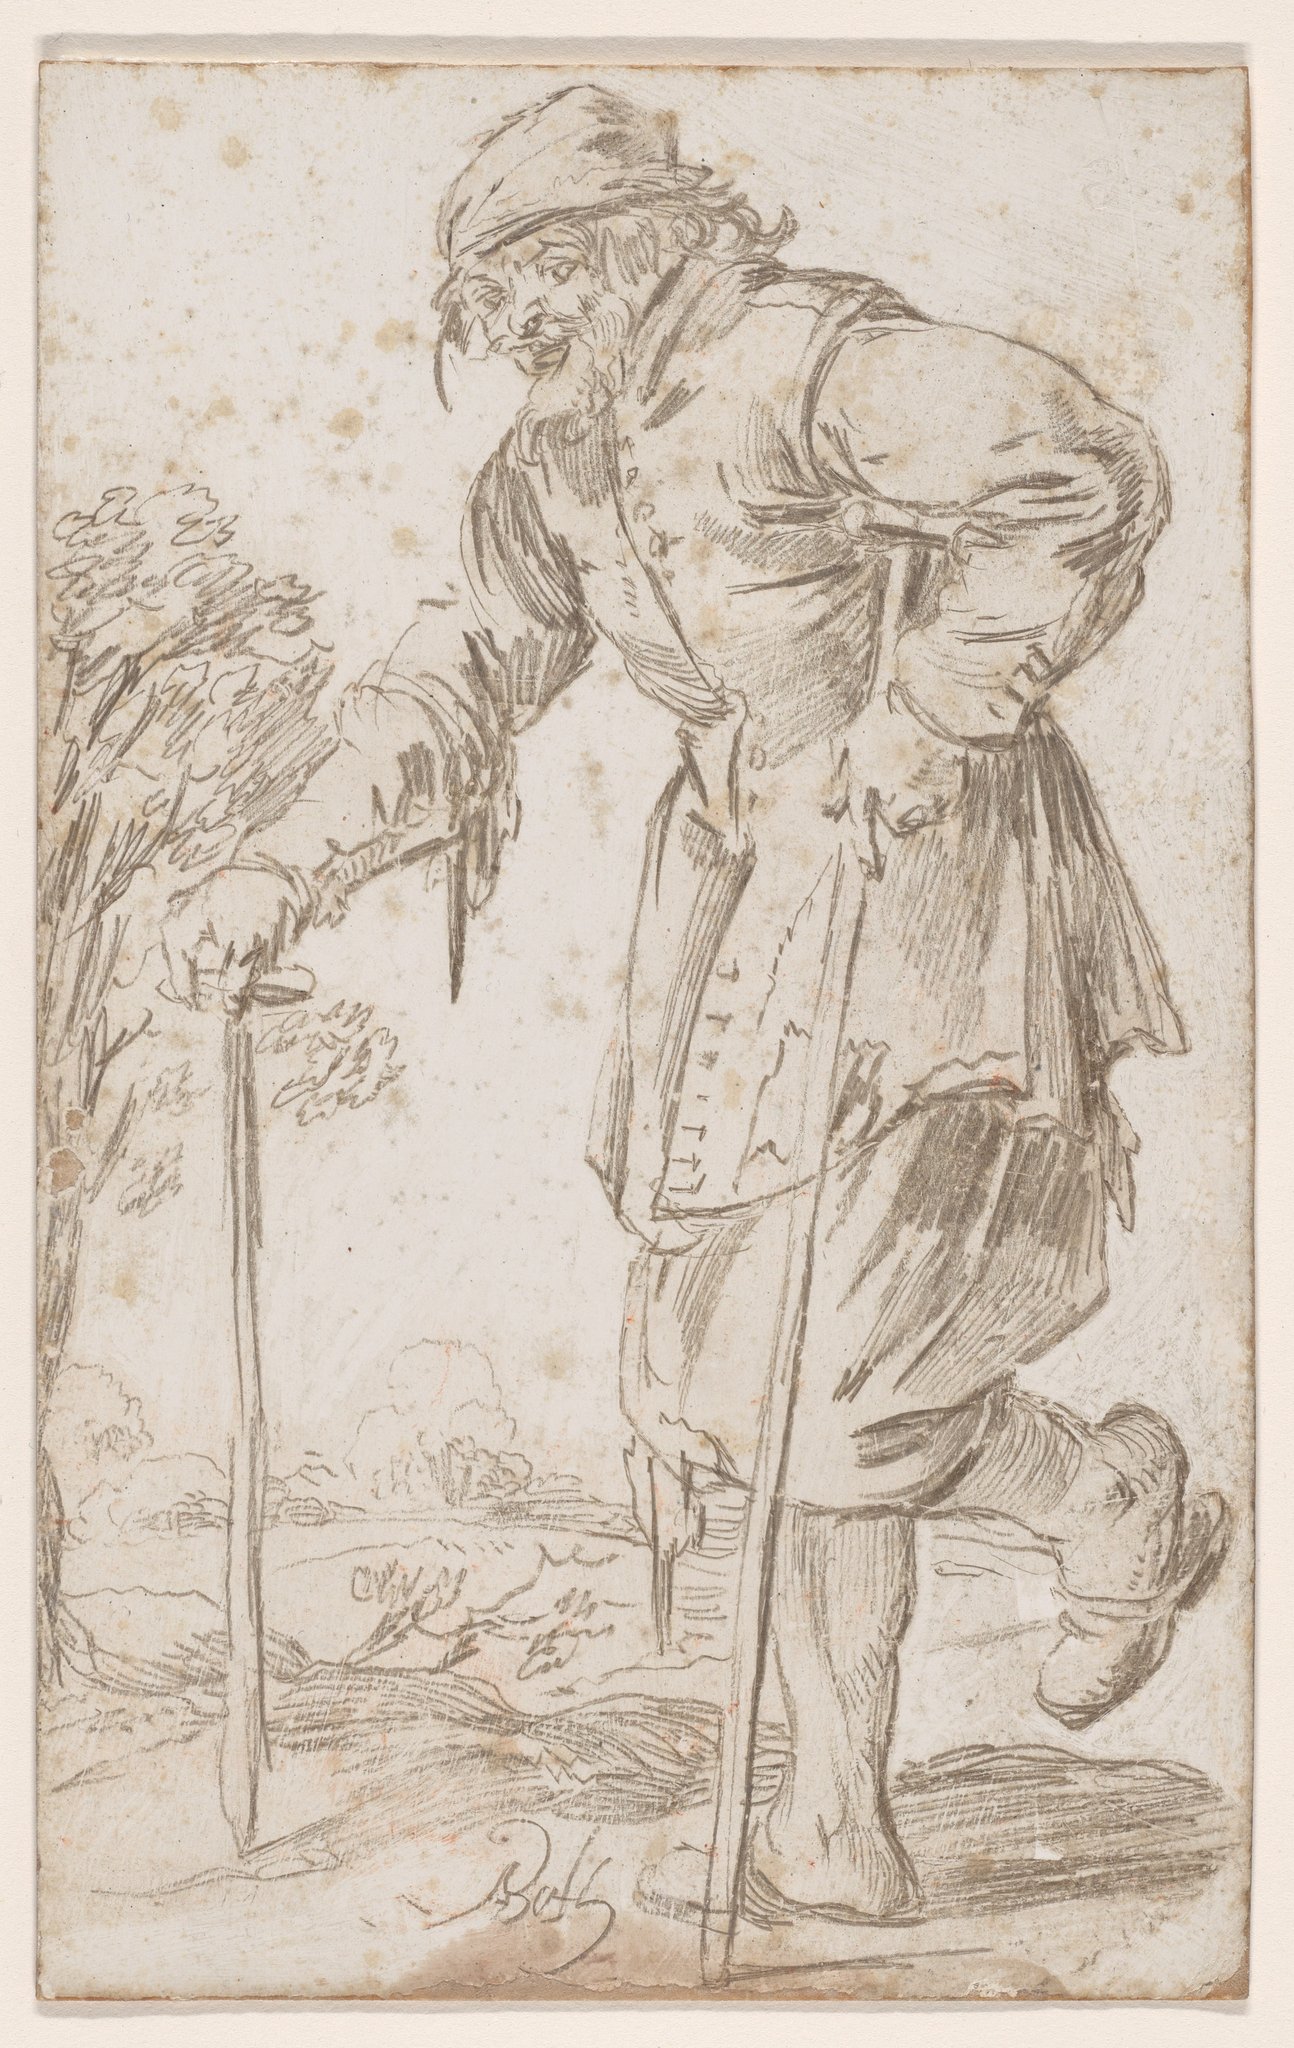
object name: drawing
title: Beggar Walking on a Crutch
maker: andries both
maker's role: artist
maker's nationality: dutch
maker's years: 1612-1641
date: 1632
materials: paper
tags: men